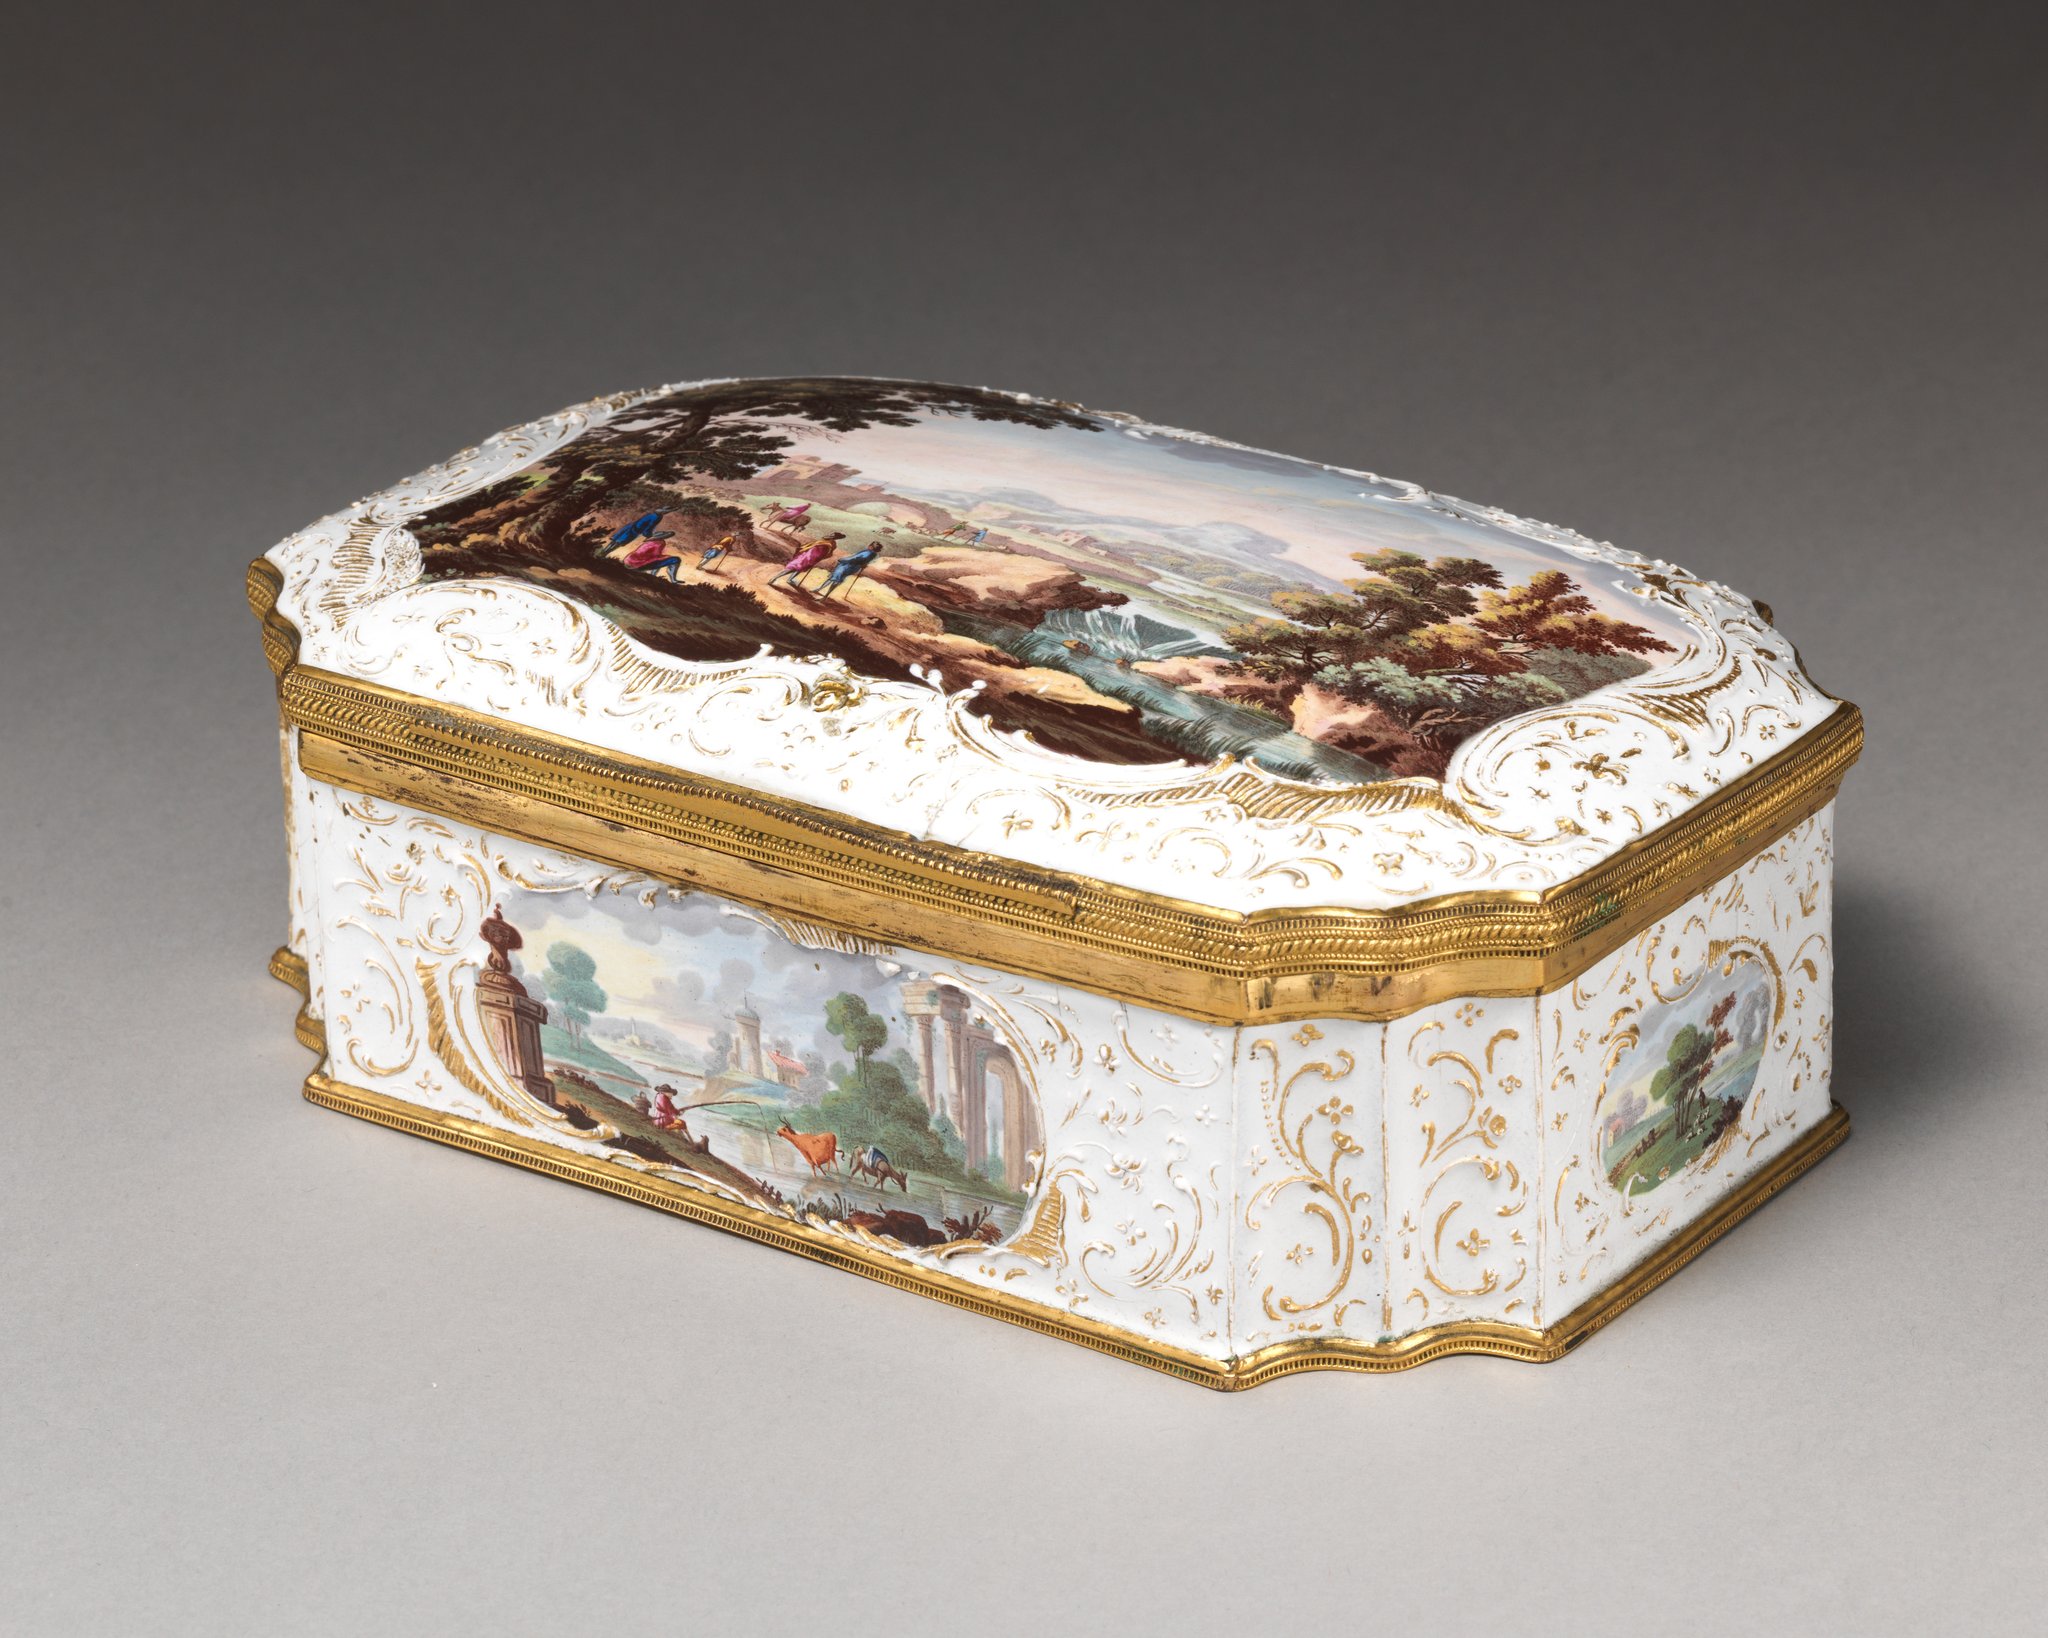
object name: box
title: Toilet box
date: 1765-1770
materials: copper, enamel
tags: human figures,landscapes,trees